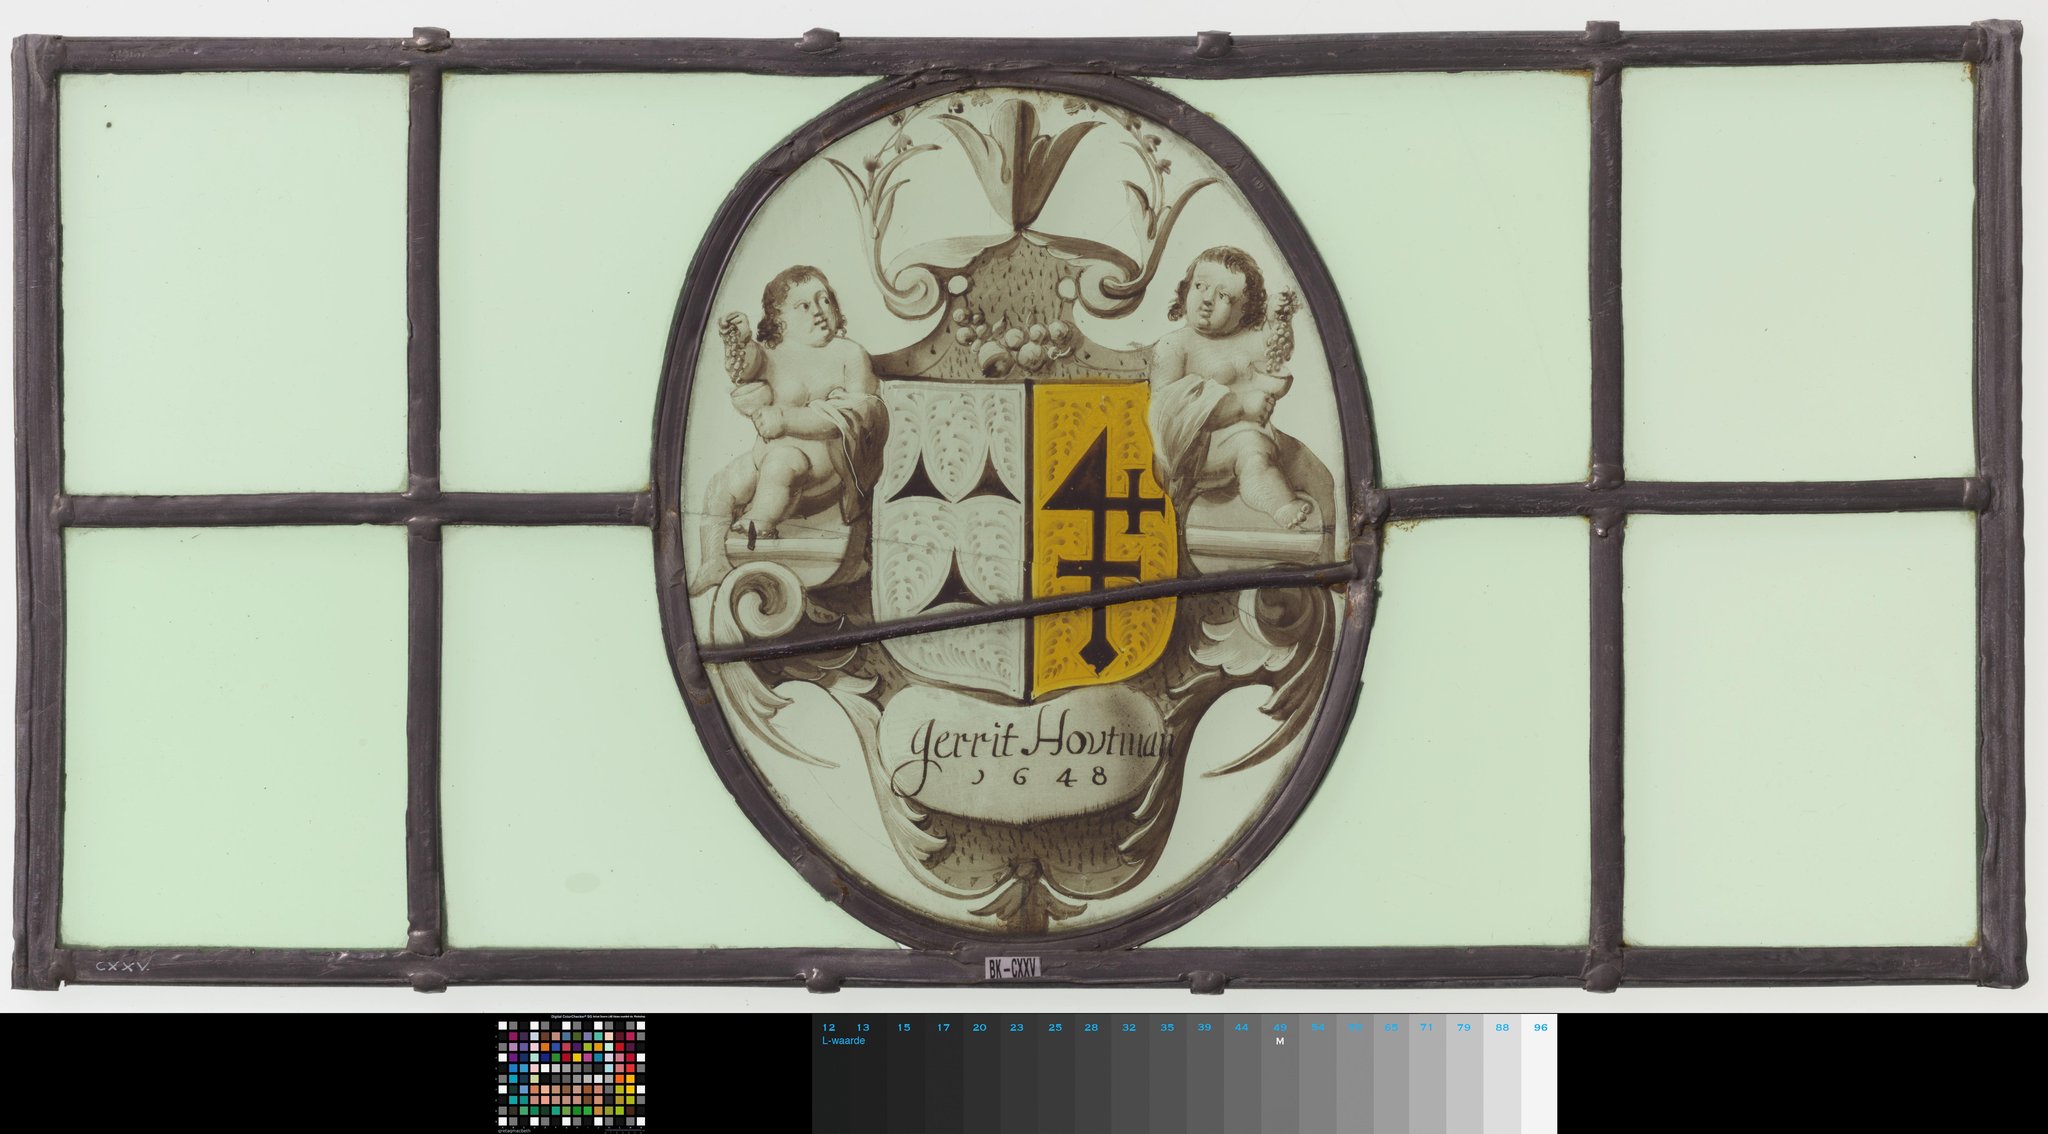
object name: wapenruit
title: Wapenruit met onderschrift "Gerrit Houtman 1648".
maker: Anonymous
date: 1648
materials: glass, lead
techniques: leading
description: Ovale wapenruit met onderschrift: "Gerrit Houtman 1648".